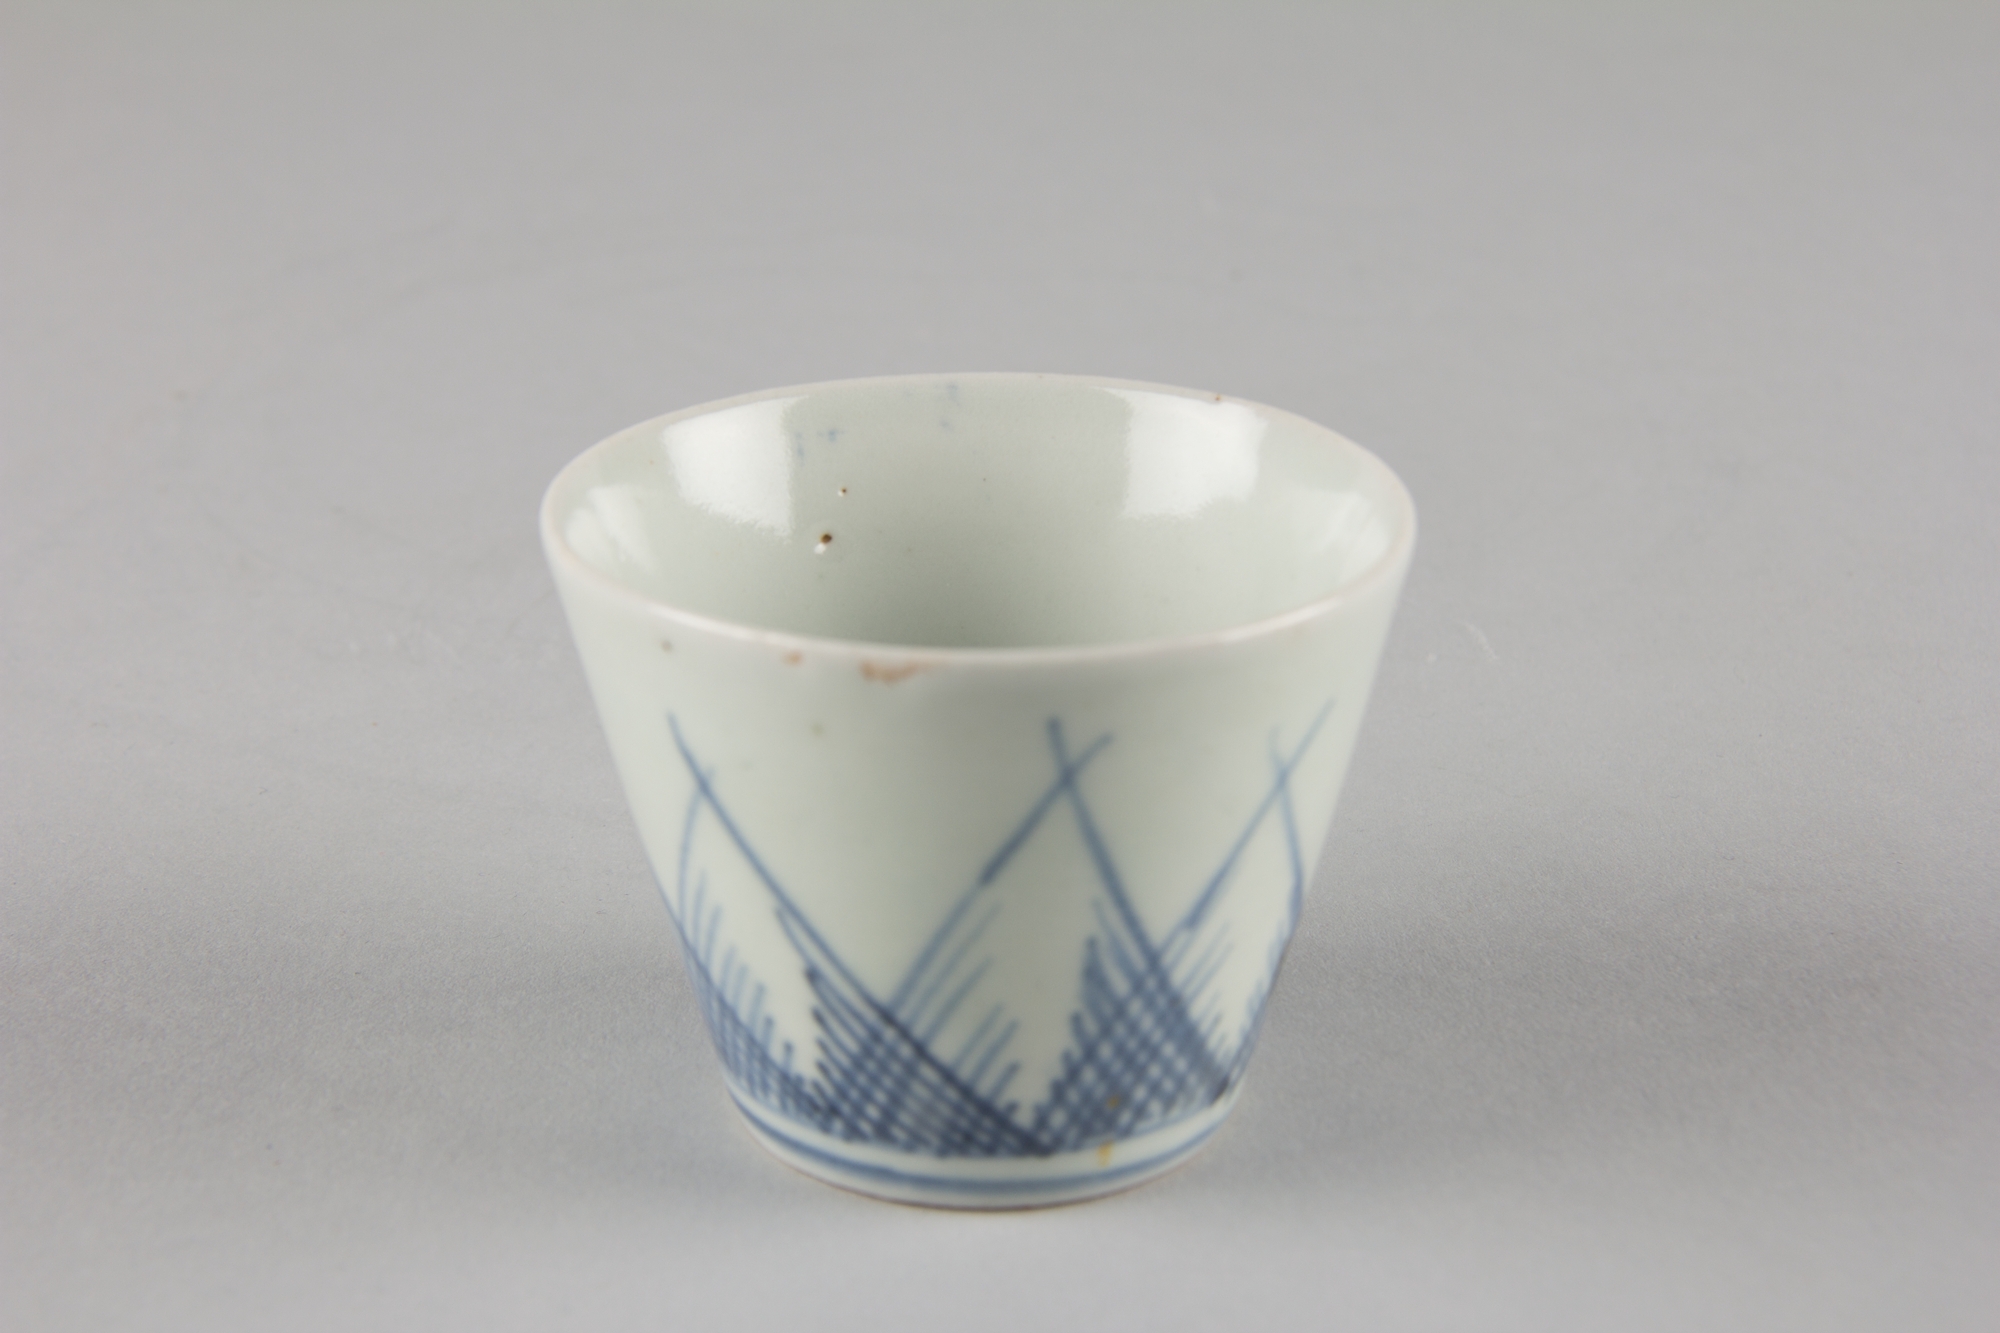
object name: soba cup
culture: japanese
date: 1751-1800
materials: porcelain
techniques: underglaze